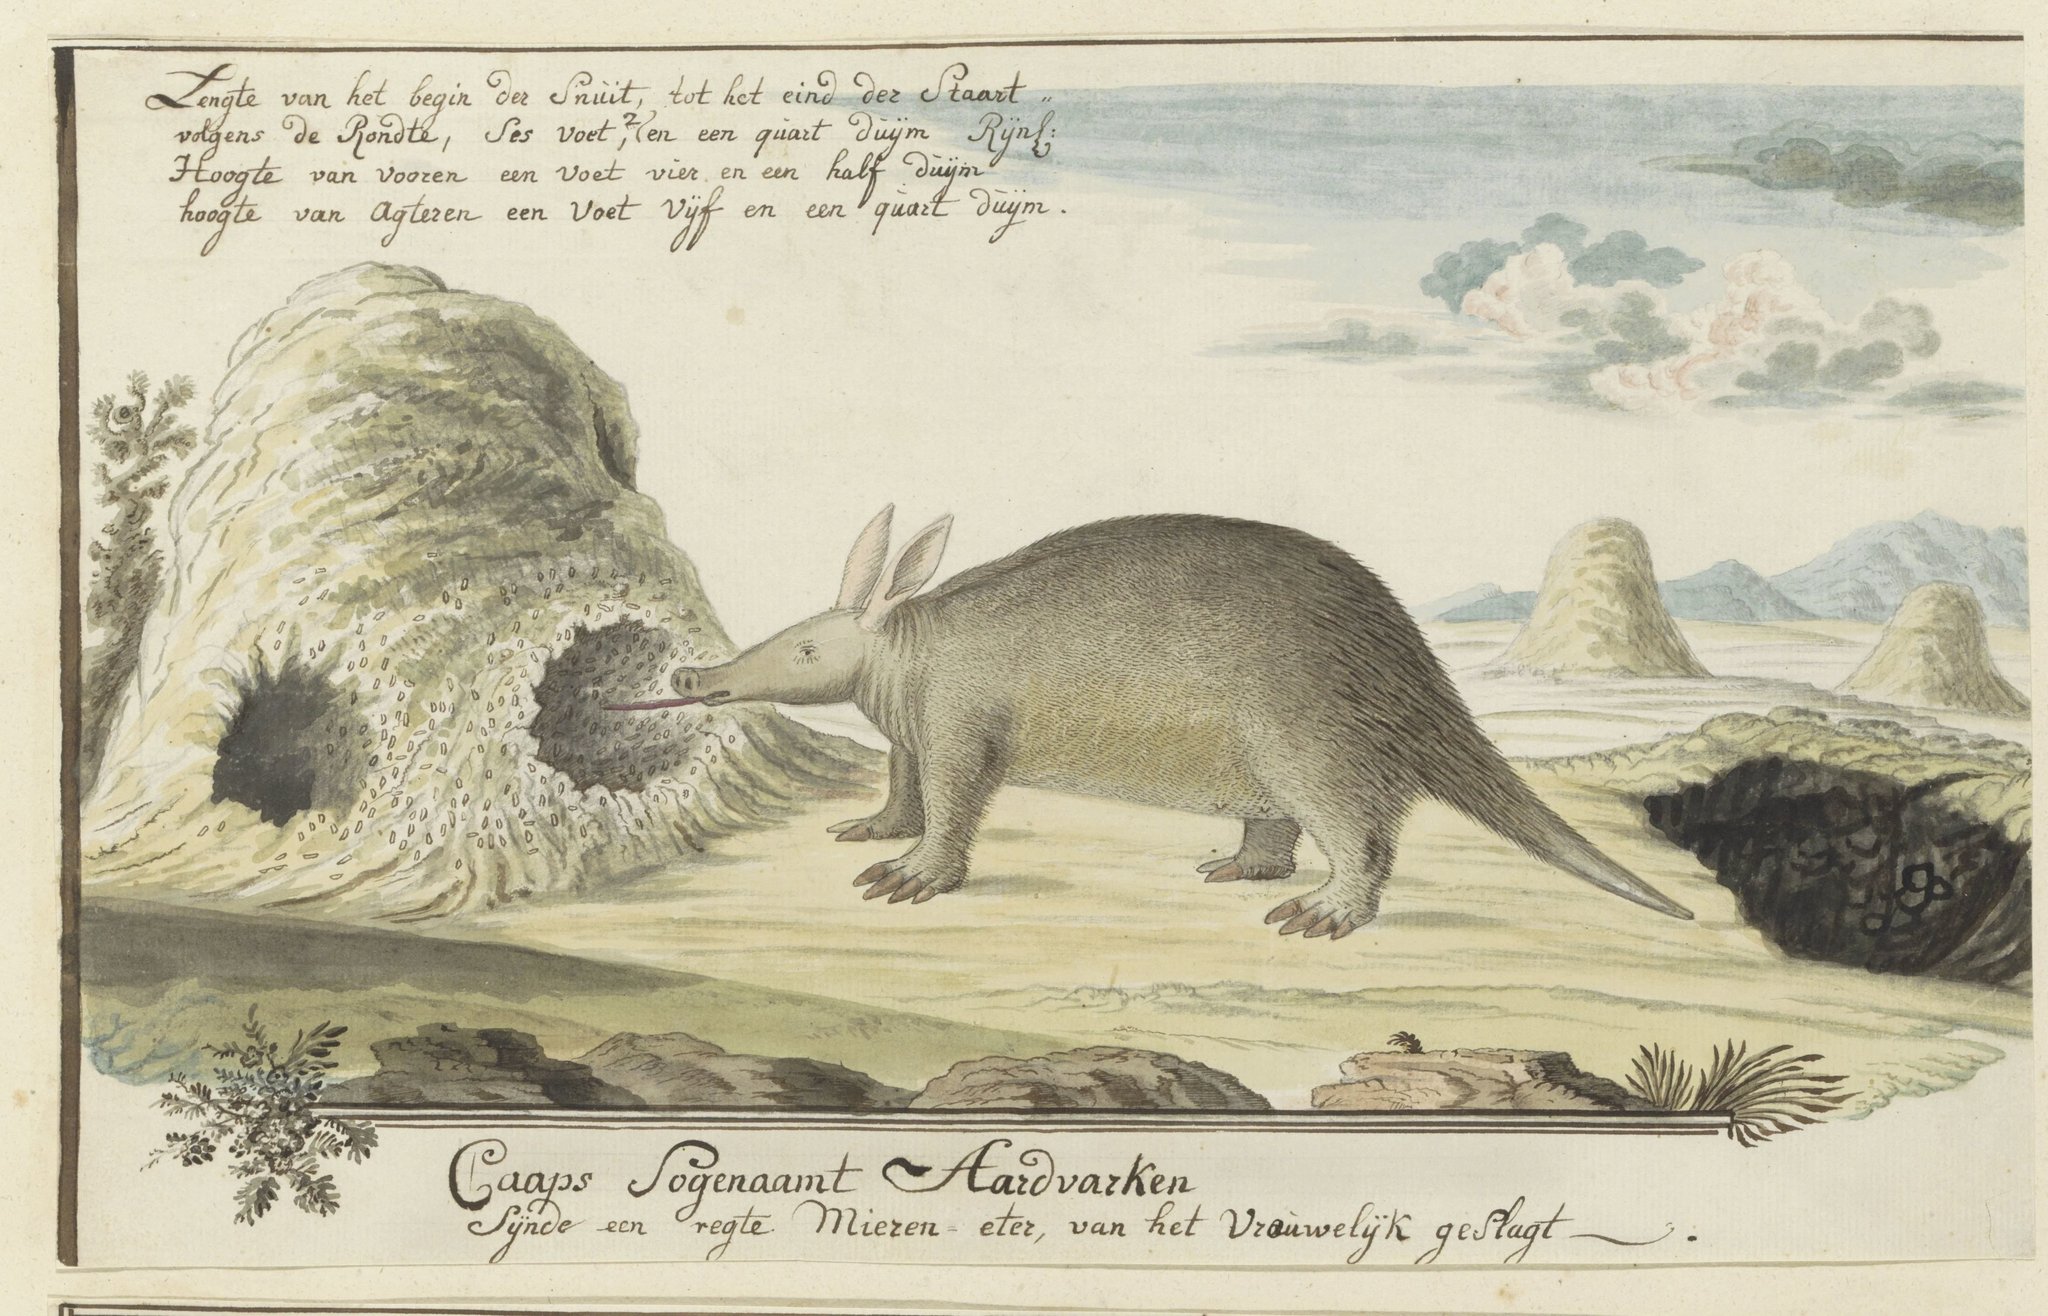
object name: album leaf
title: Orycteropus afer (Aardvark)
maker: robert jacob gordon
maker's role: draughtsman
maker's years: 1743-1795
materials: chalk, ink, paper, pencil, watercolor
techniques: brush, pen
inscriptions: annotation: ‘onderaan: Caaps Sogenaamt Aardvarken / sijnde een regte Mieren - eter, van het Vrouwelijk geslagt ~.’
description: Een miereneter van het vrouwelijk geslacht.